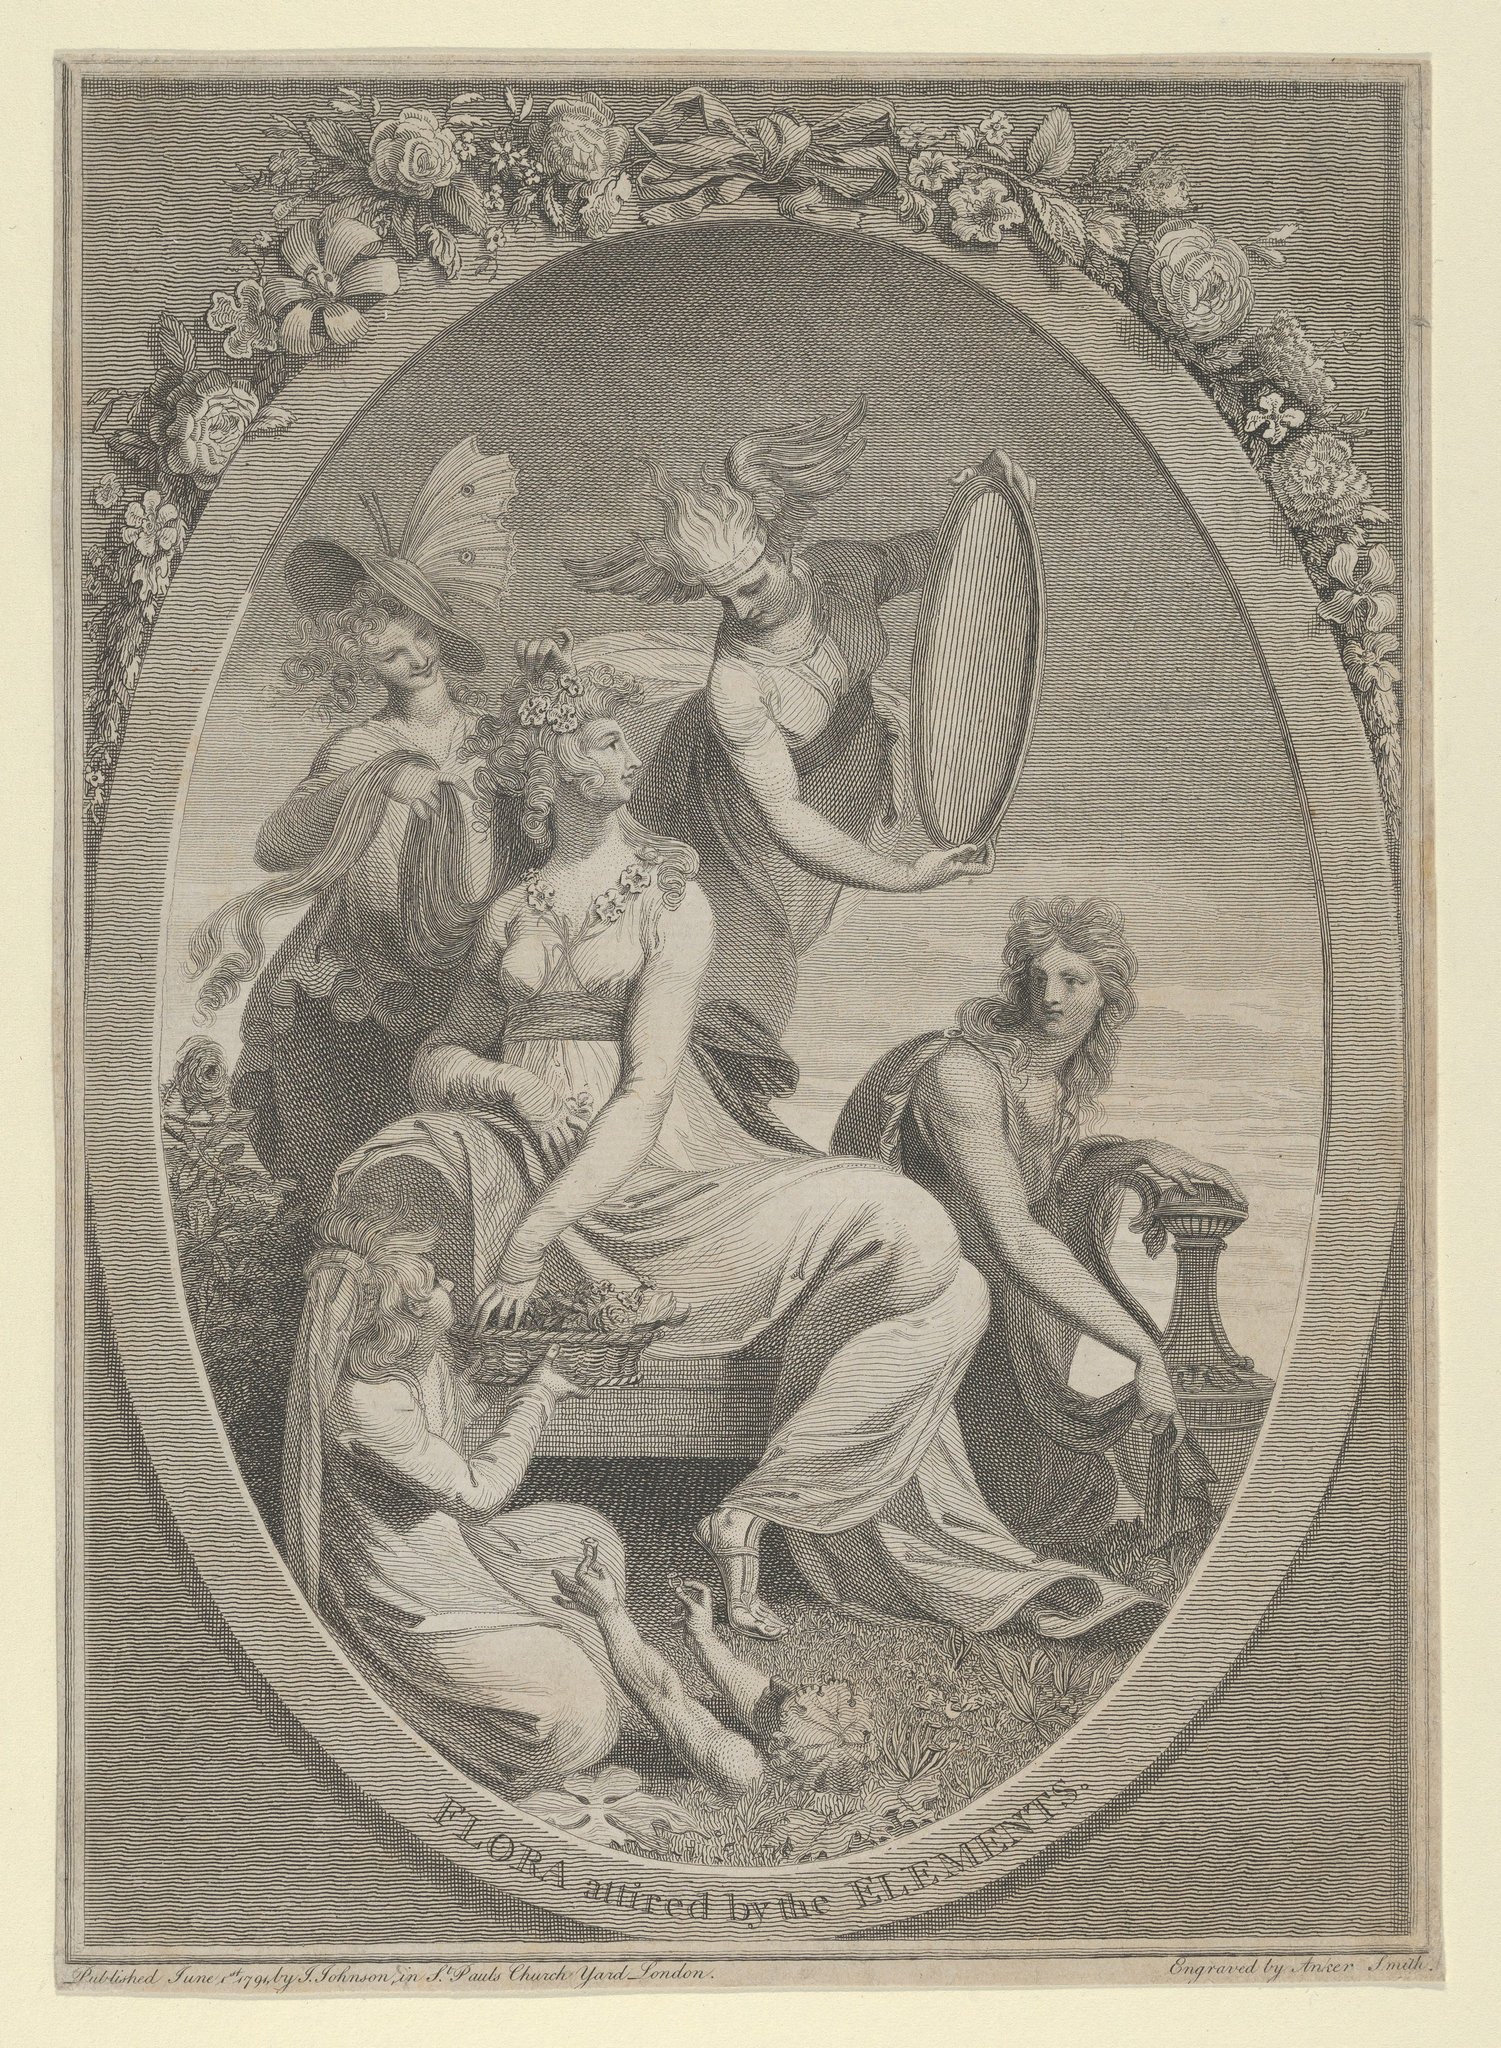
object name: print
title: Flora Attired by the Elements (Frontispiece to The Economy of Vegetation, vol. I of Erasmus Darwin's The Botanic Garden)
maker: anker smith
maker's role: engraver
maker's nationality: british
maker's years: 1759-1819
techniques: engraving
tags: women,flowers,mirrors